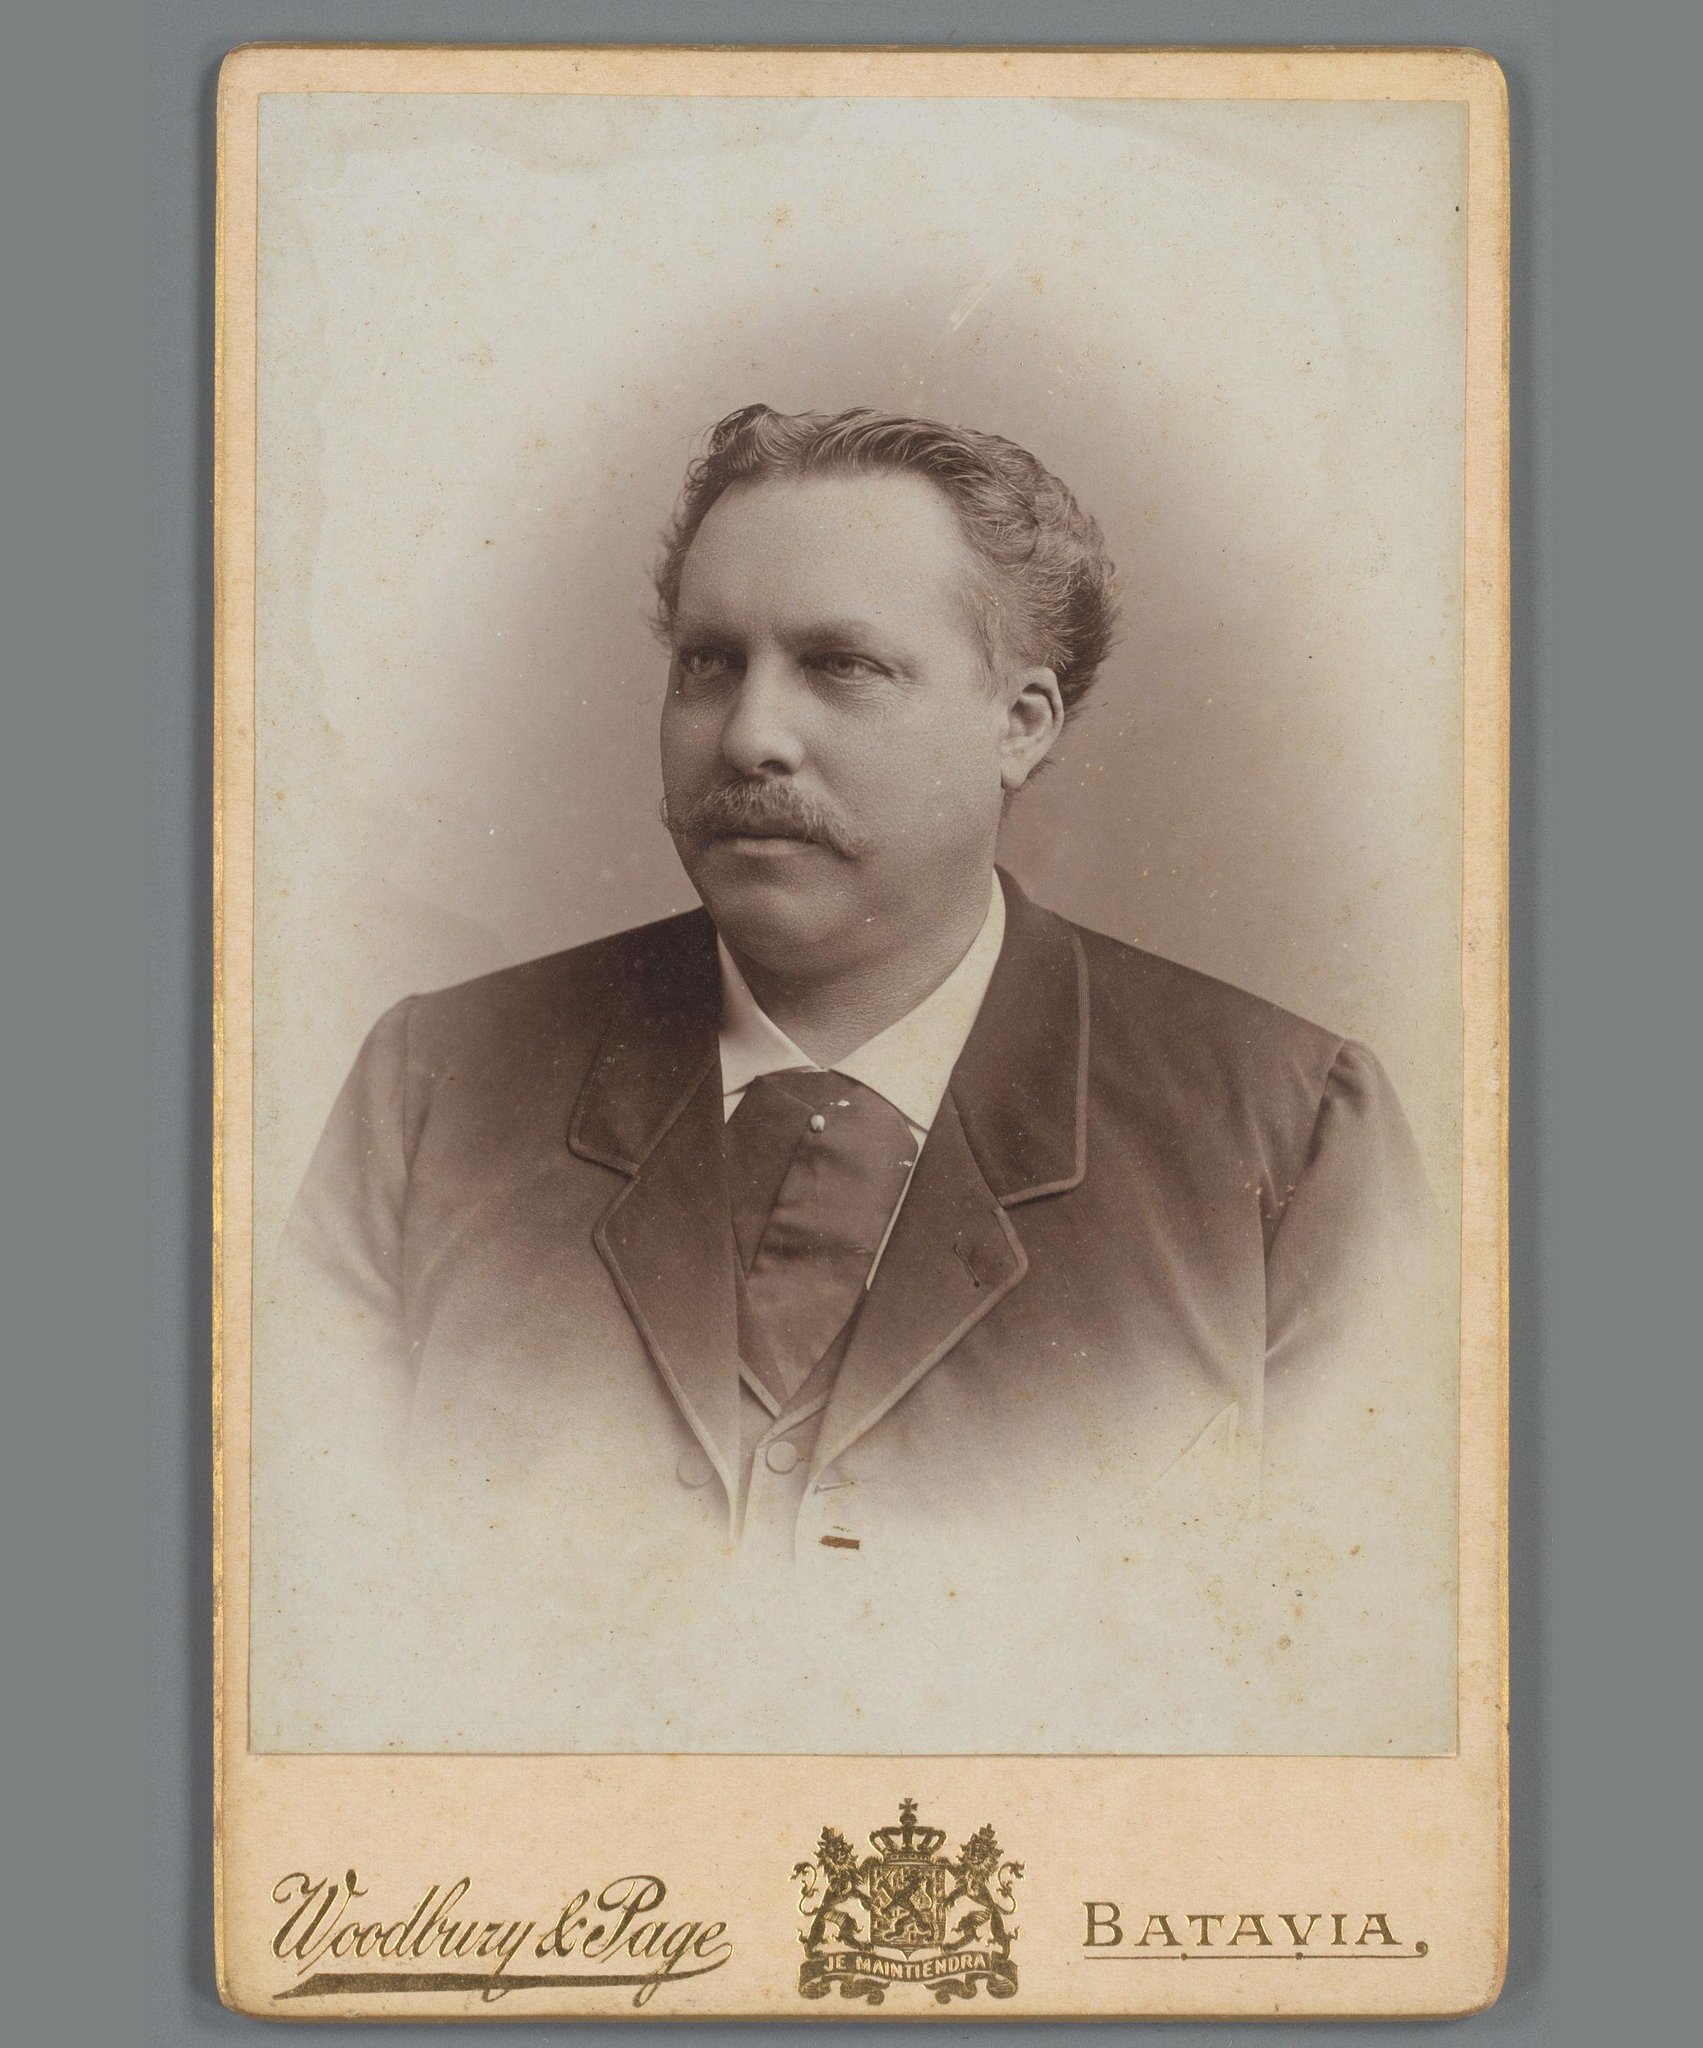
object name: cabinet photograph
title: Portret van een onbekende man, mogelijk een lid van de familie Onnen-van den Berg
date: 1890-1908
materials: paper, cardboard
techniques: gelatin silver print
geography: batavia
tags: anonymous historical person portrayed